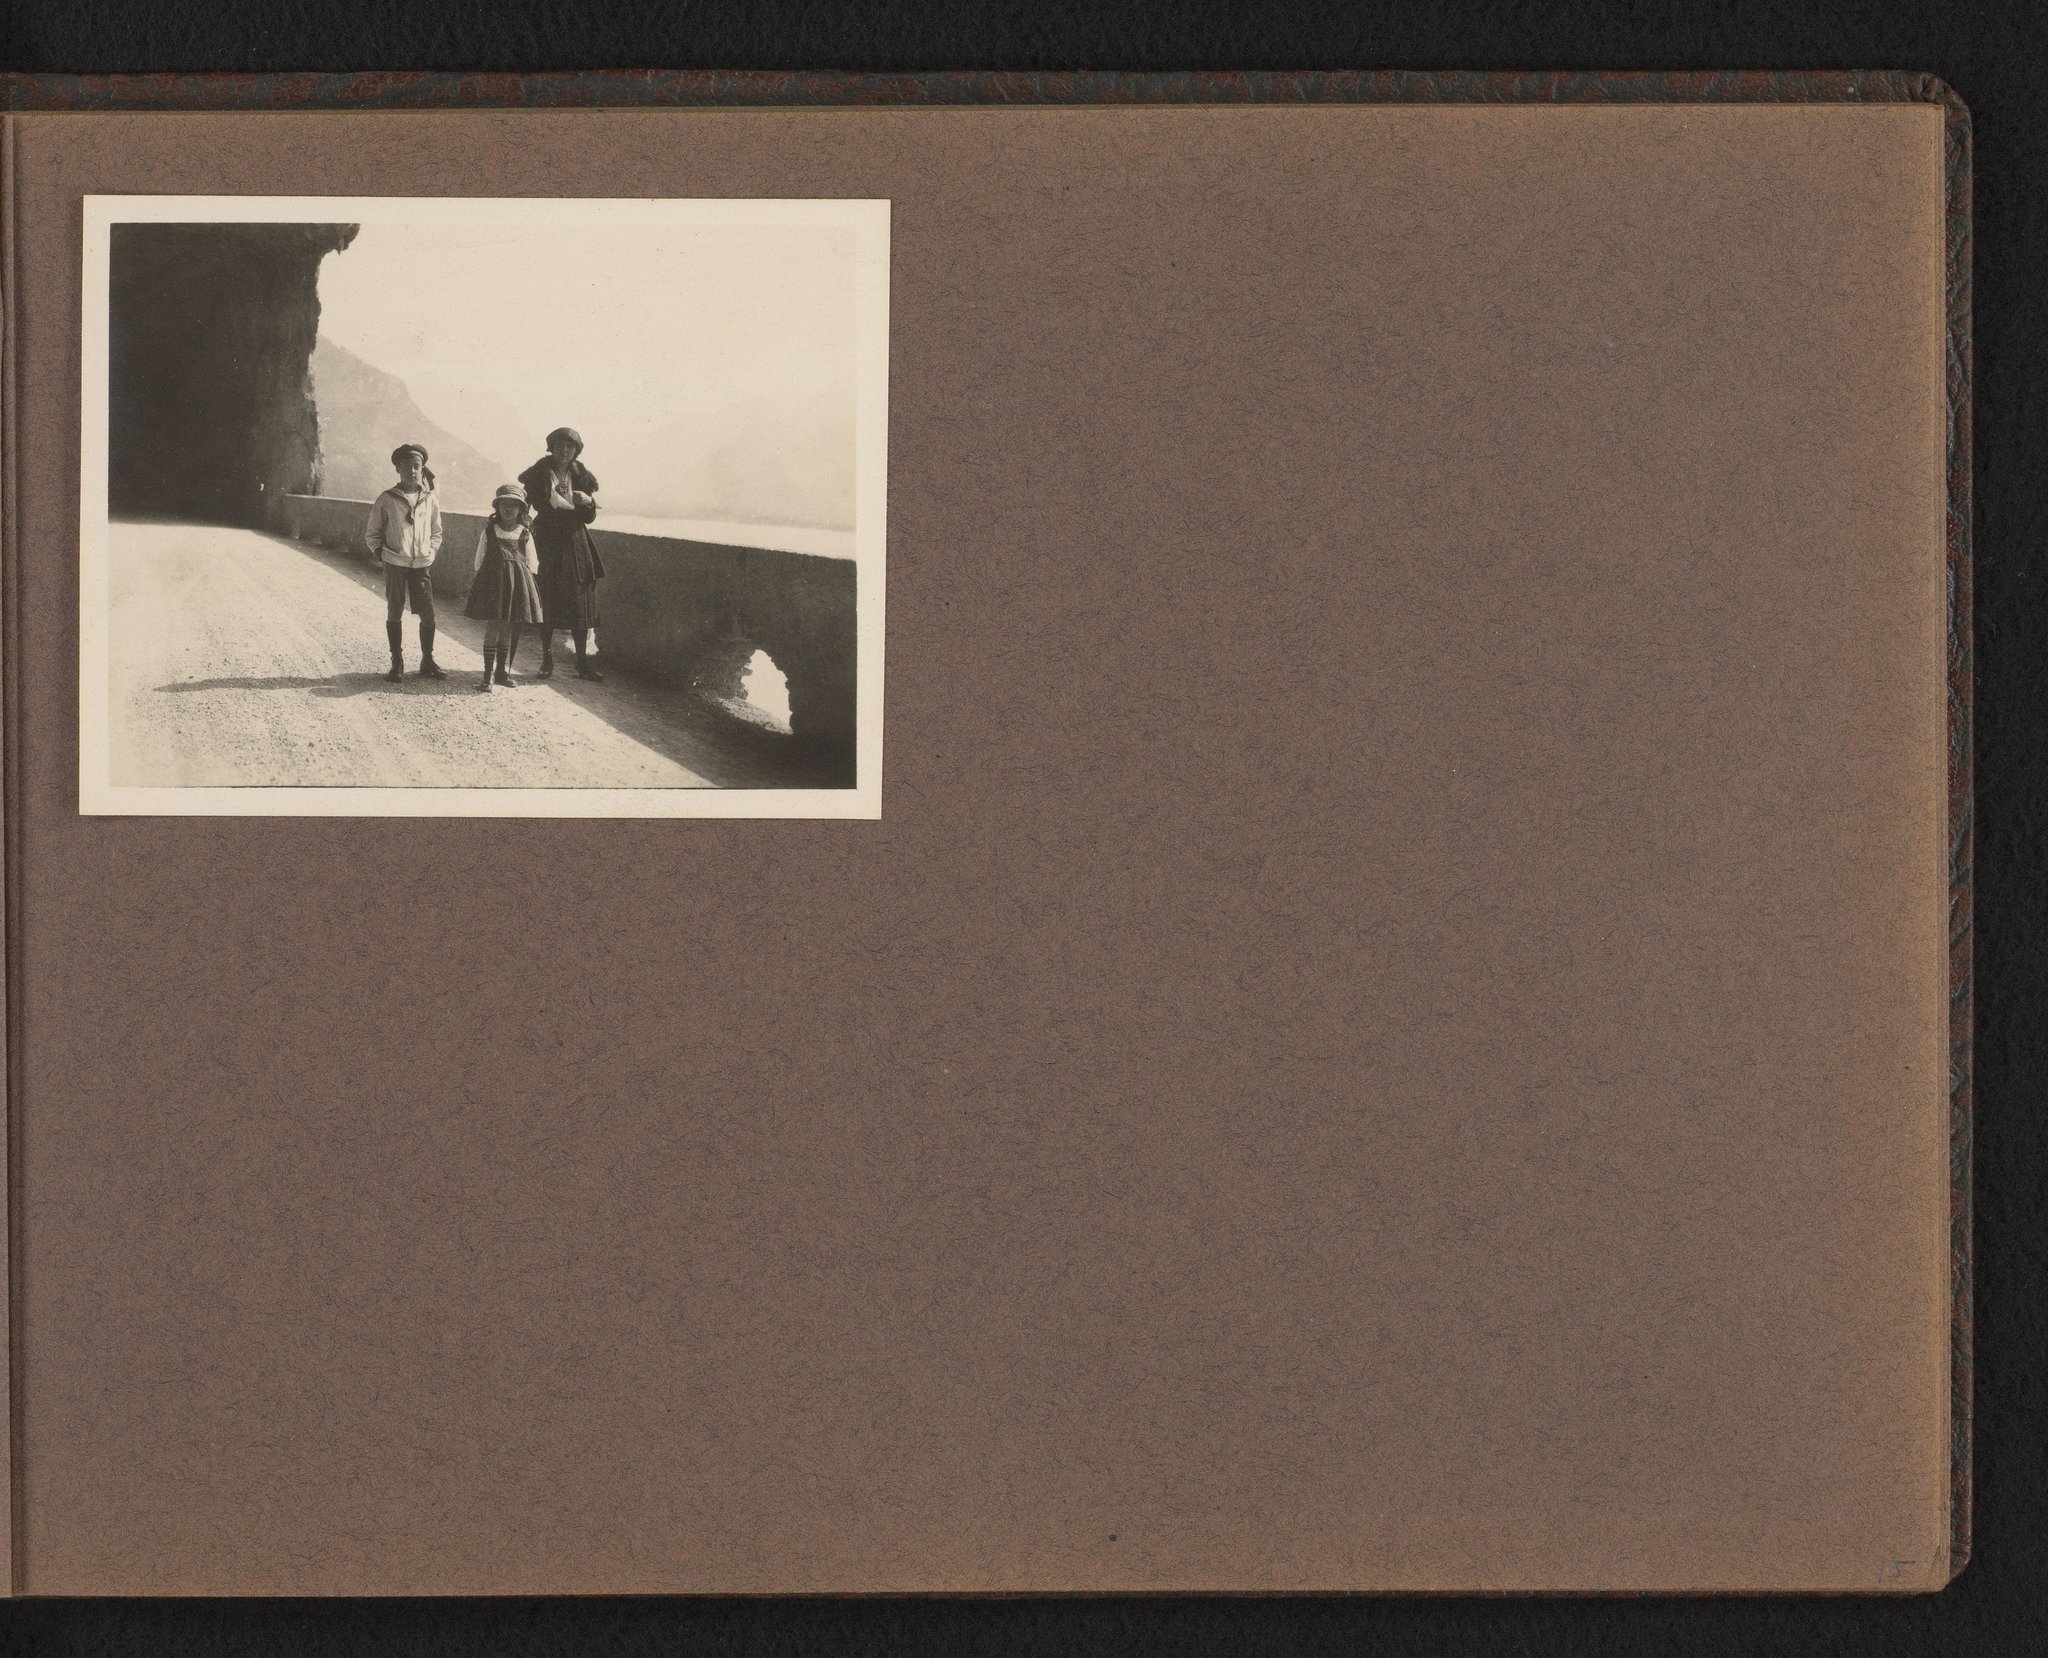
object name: album leaf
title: Foto van de familie op vakantie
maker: frédéric gabriël dumas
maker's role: engineer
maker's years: 1886-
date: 1919-1923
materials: cardboard, photographic support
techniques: gelatin silver print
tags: surabaya, paris, beatrice jacqueline eveline dumas, outing, pleasure trip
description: Blad met een foto van de familie op vakantie, staande bij een muur langs een weg. Onderdeel van een fotoalbum over de kindertijd van Eef Dumas met de familie op reis door Europa, ca. 1919-1923.